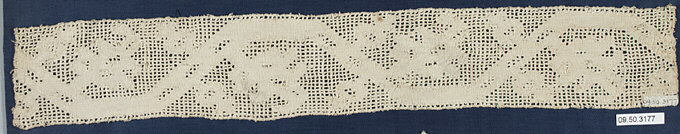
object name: band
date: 1601-1800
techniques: embroidery